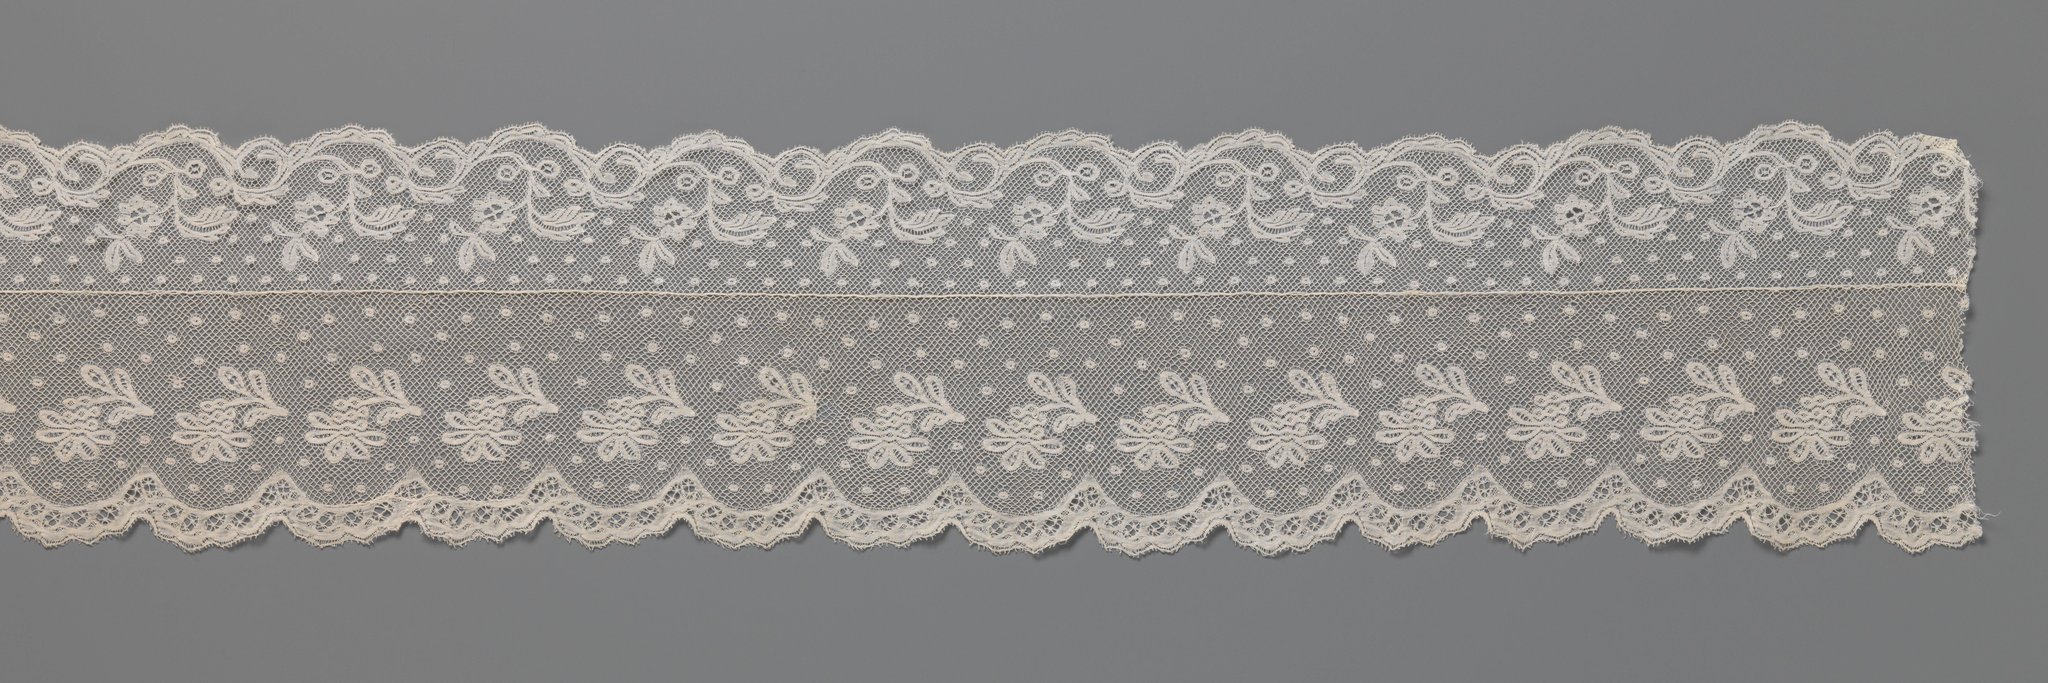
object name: strip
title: Strook kloskant met kromme takjes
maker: Anonymous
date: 1875-1899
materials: linen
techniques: lace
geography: sluis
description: Op een grof en met moesjes bezaaid mazenfond (vierkante maas) staat, boven een halfcirkelvormige schulp, een open patroon van een overhangend takje met een bloem. Valenciennes-kant. Oorspronkelijk was deze strook één van de delen van een strook die uit vier losse delen bestond. Hiervan zijn er echter drie aan elkaar genaaid: BK-BR-J-259-A, -B, -C. In 1966 is aan deze bovenzijde van de lange strook die zo is ontstaan, vervolgens een iets smallere strook gezet, BK-BR-J-321-A, met een enigszins vergelijkbaar patroon.